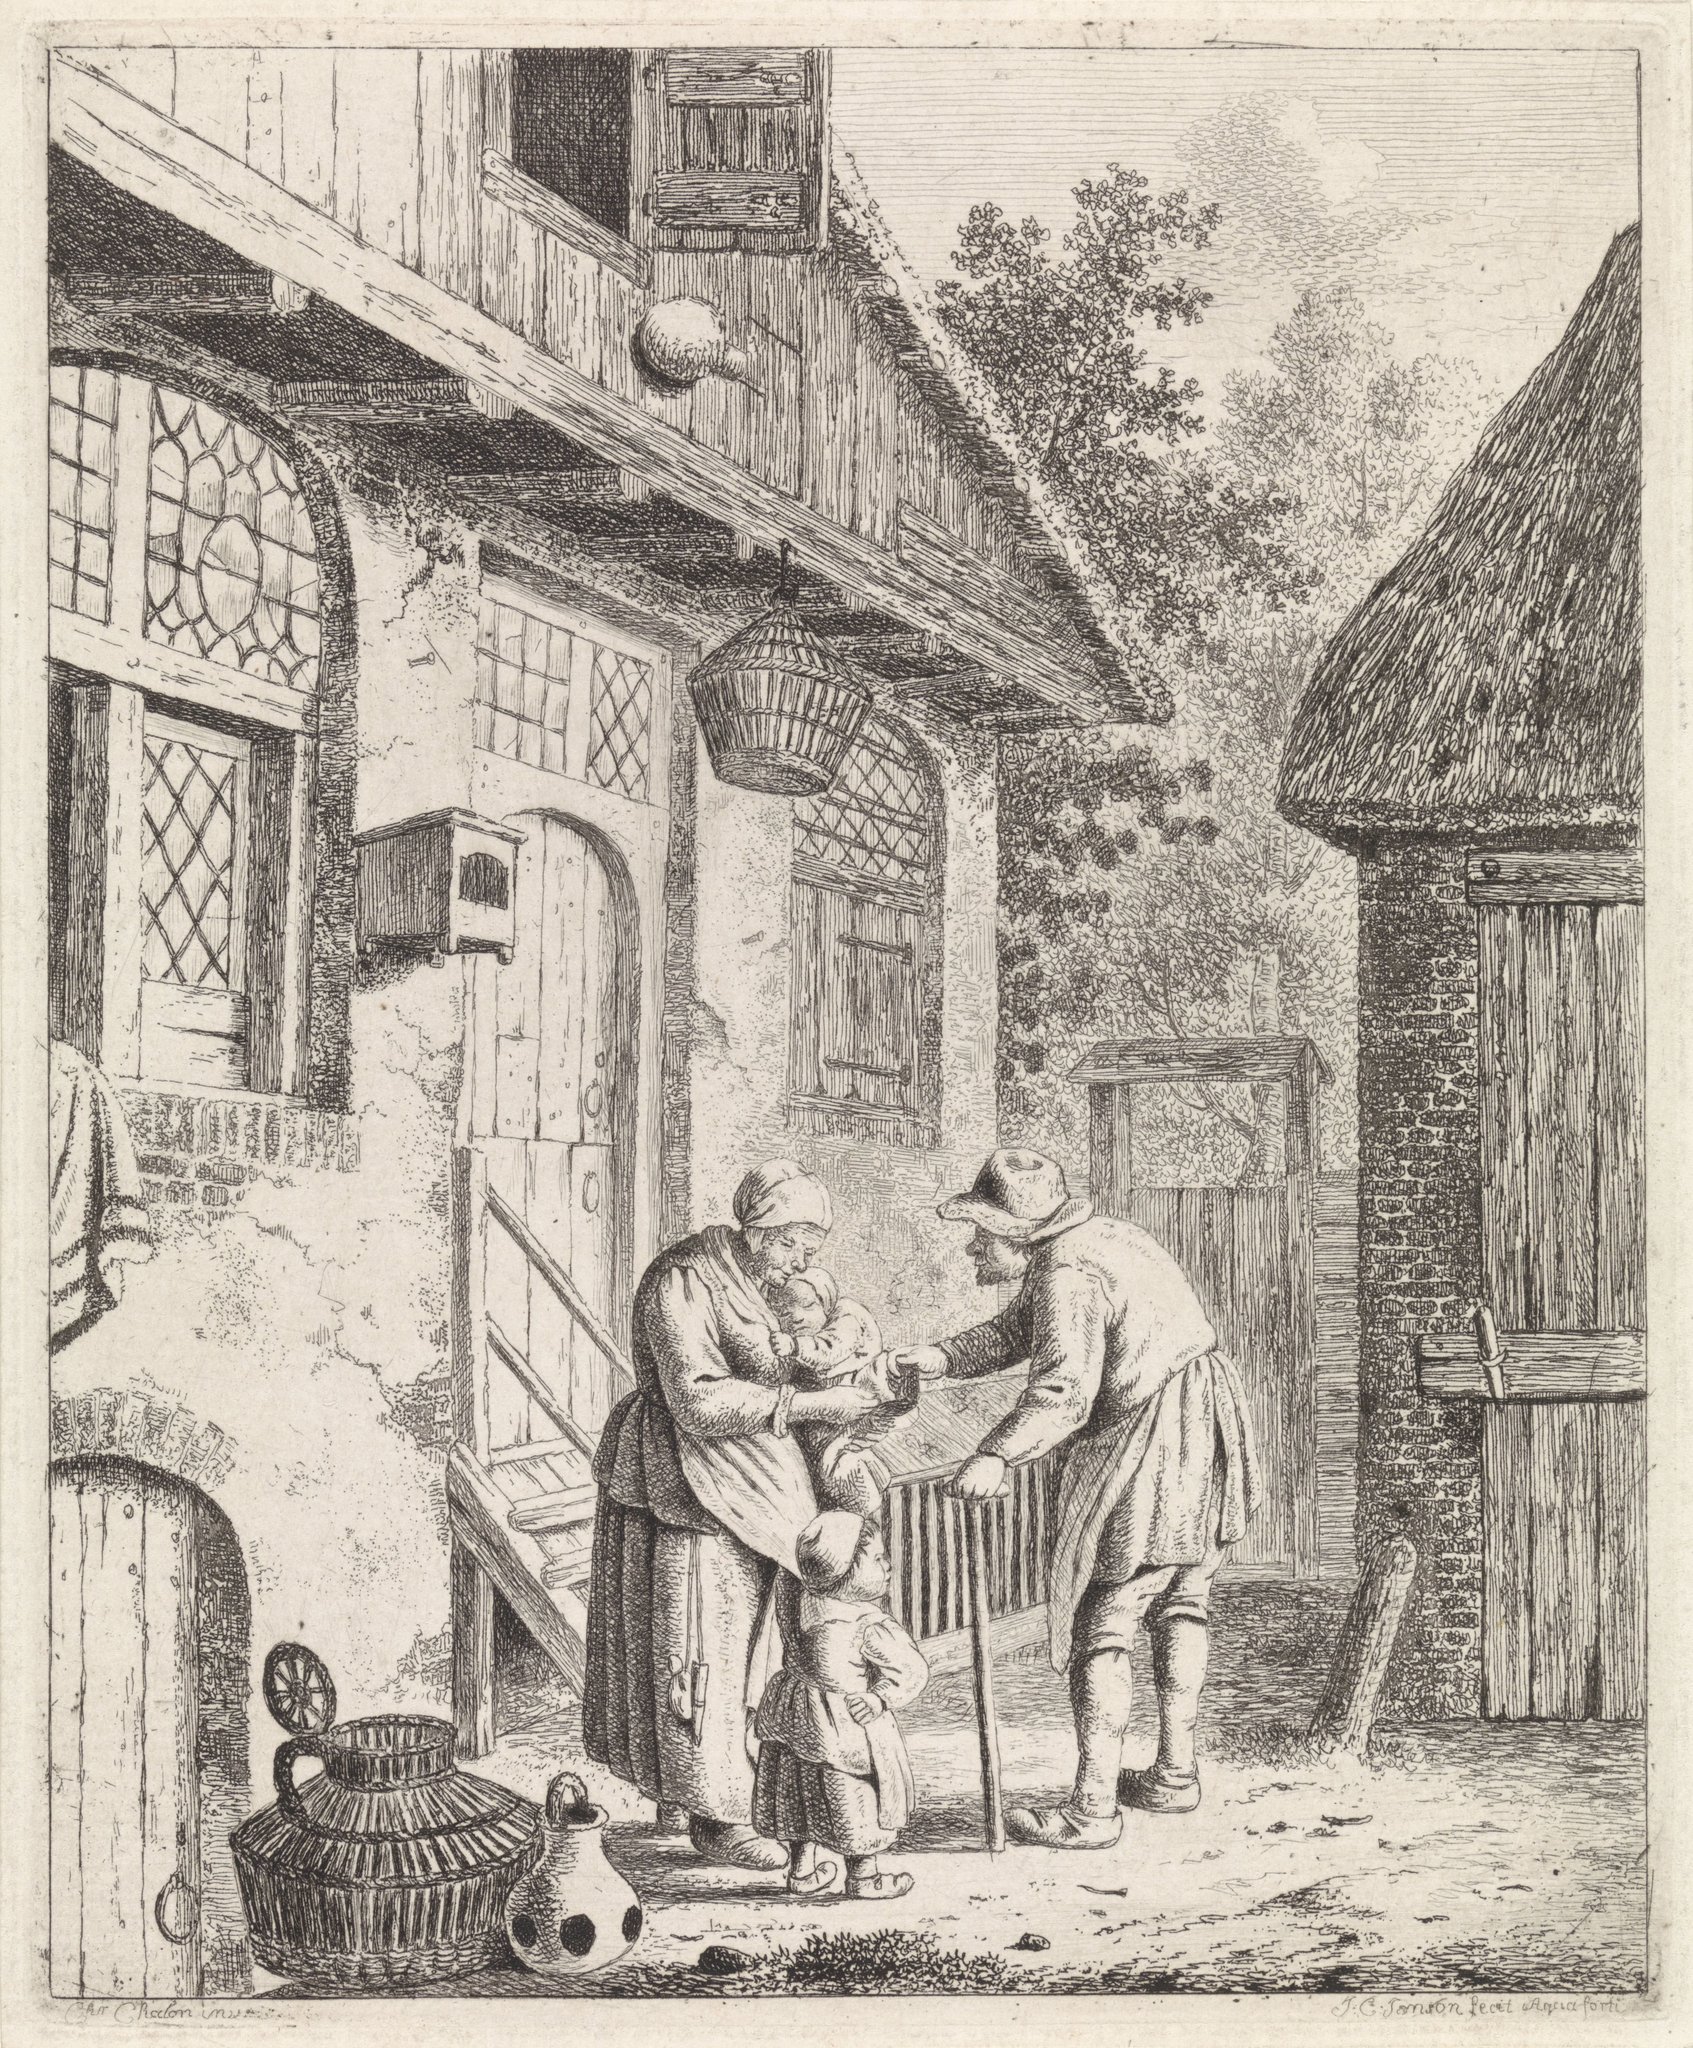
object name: print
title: Binnenplaats met boeren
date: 1778-1823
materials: paper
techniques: etching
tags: mother and baby or young child, courtyard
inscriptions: inscription: ‘m’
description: Binnenplaats met een vrouw en twee kinderen voor een huis. De vrouw houdt het jongste kind op haar arm. Voor hen een man, op een stok leunend. Links op de voorgrond een mand en kan. Mét bomen op de achtergrond. Meer bewerkt dan vorige staat.